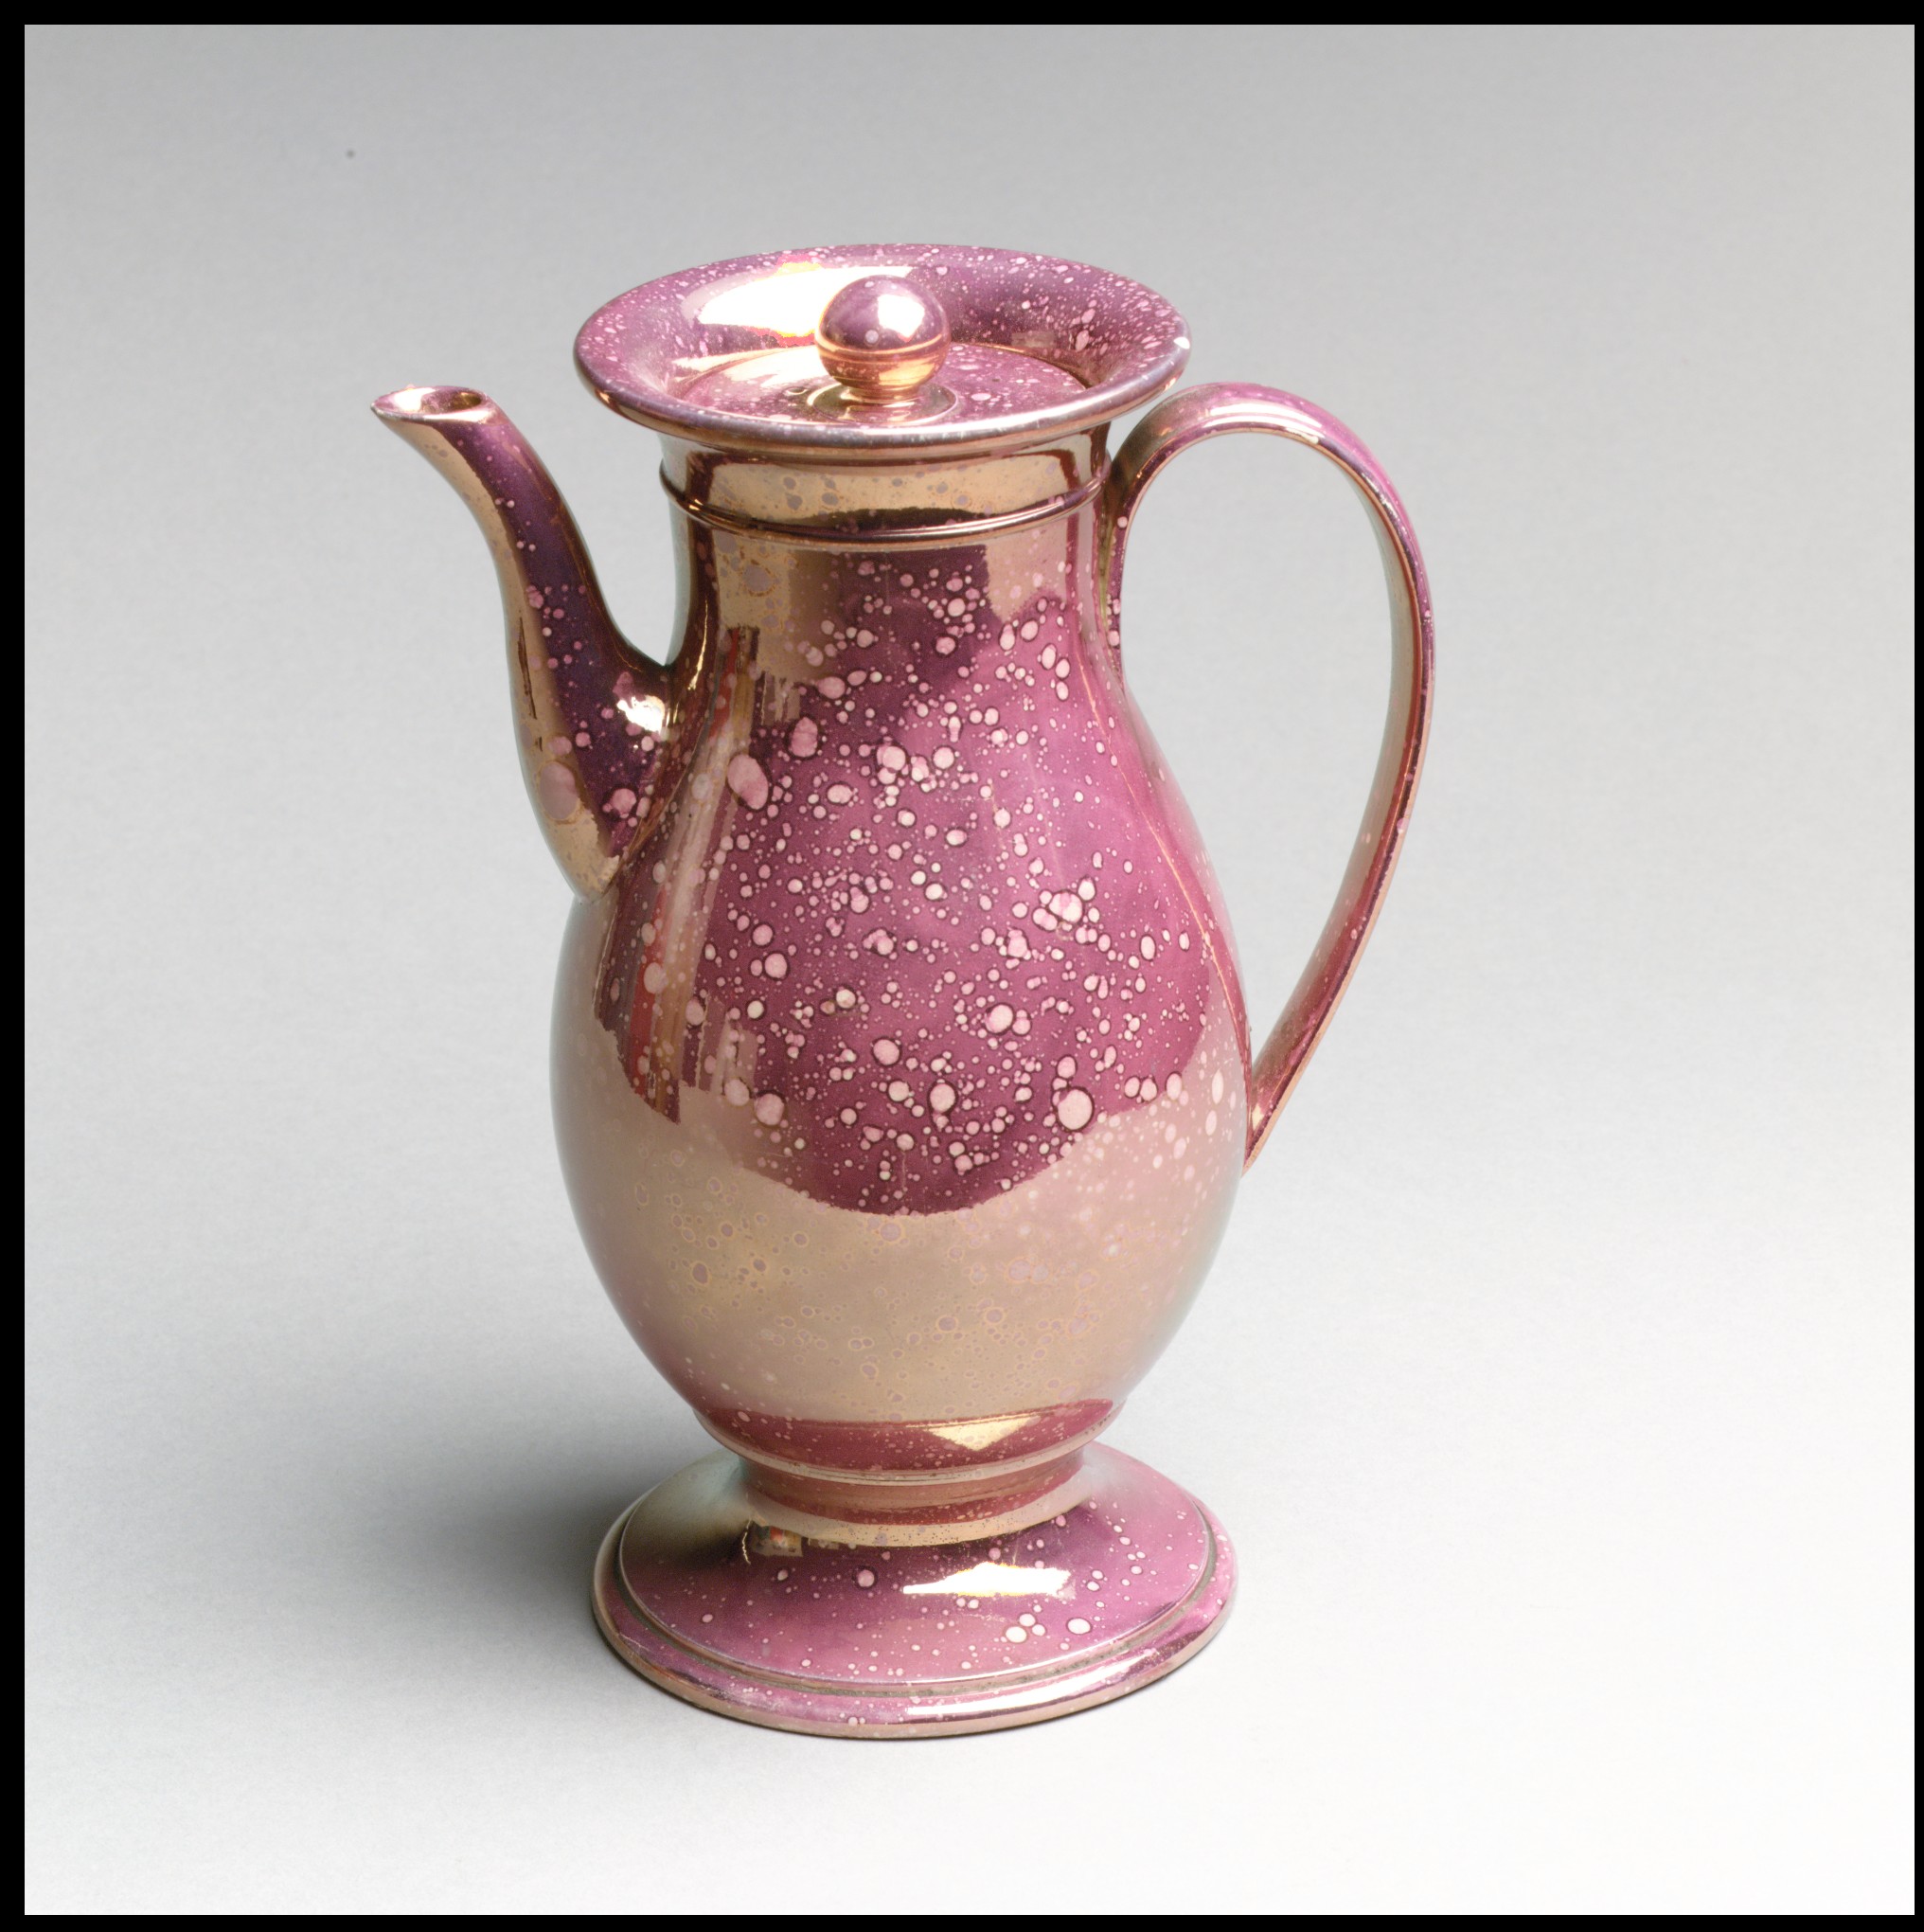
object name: coffeepot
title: Coffeepot (part of a set)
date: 1810